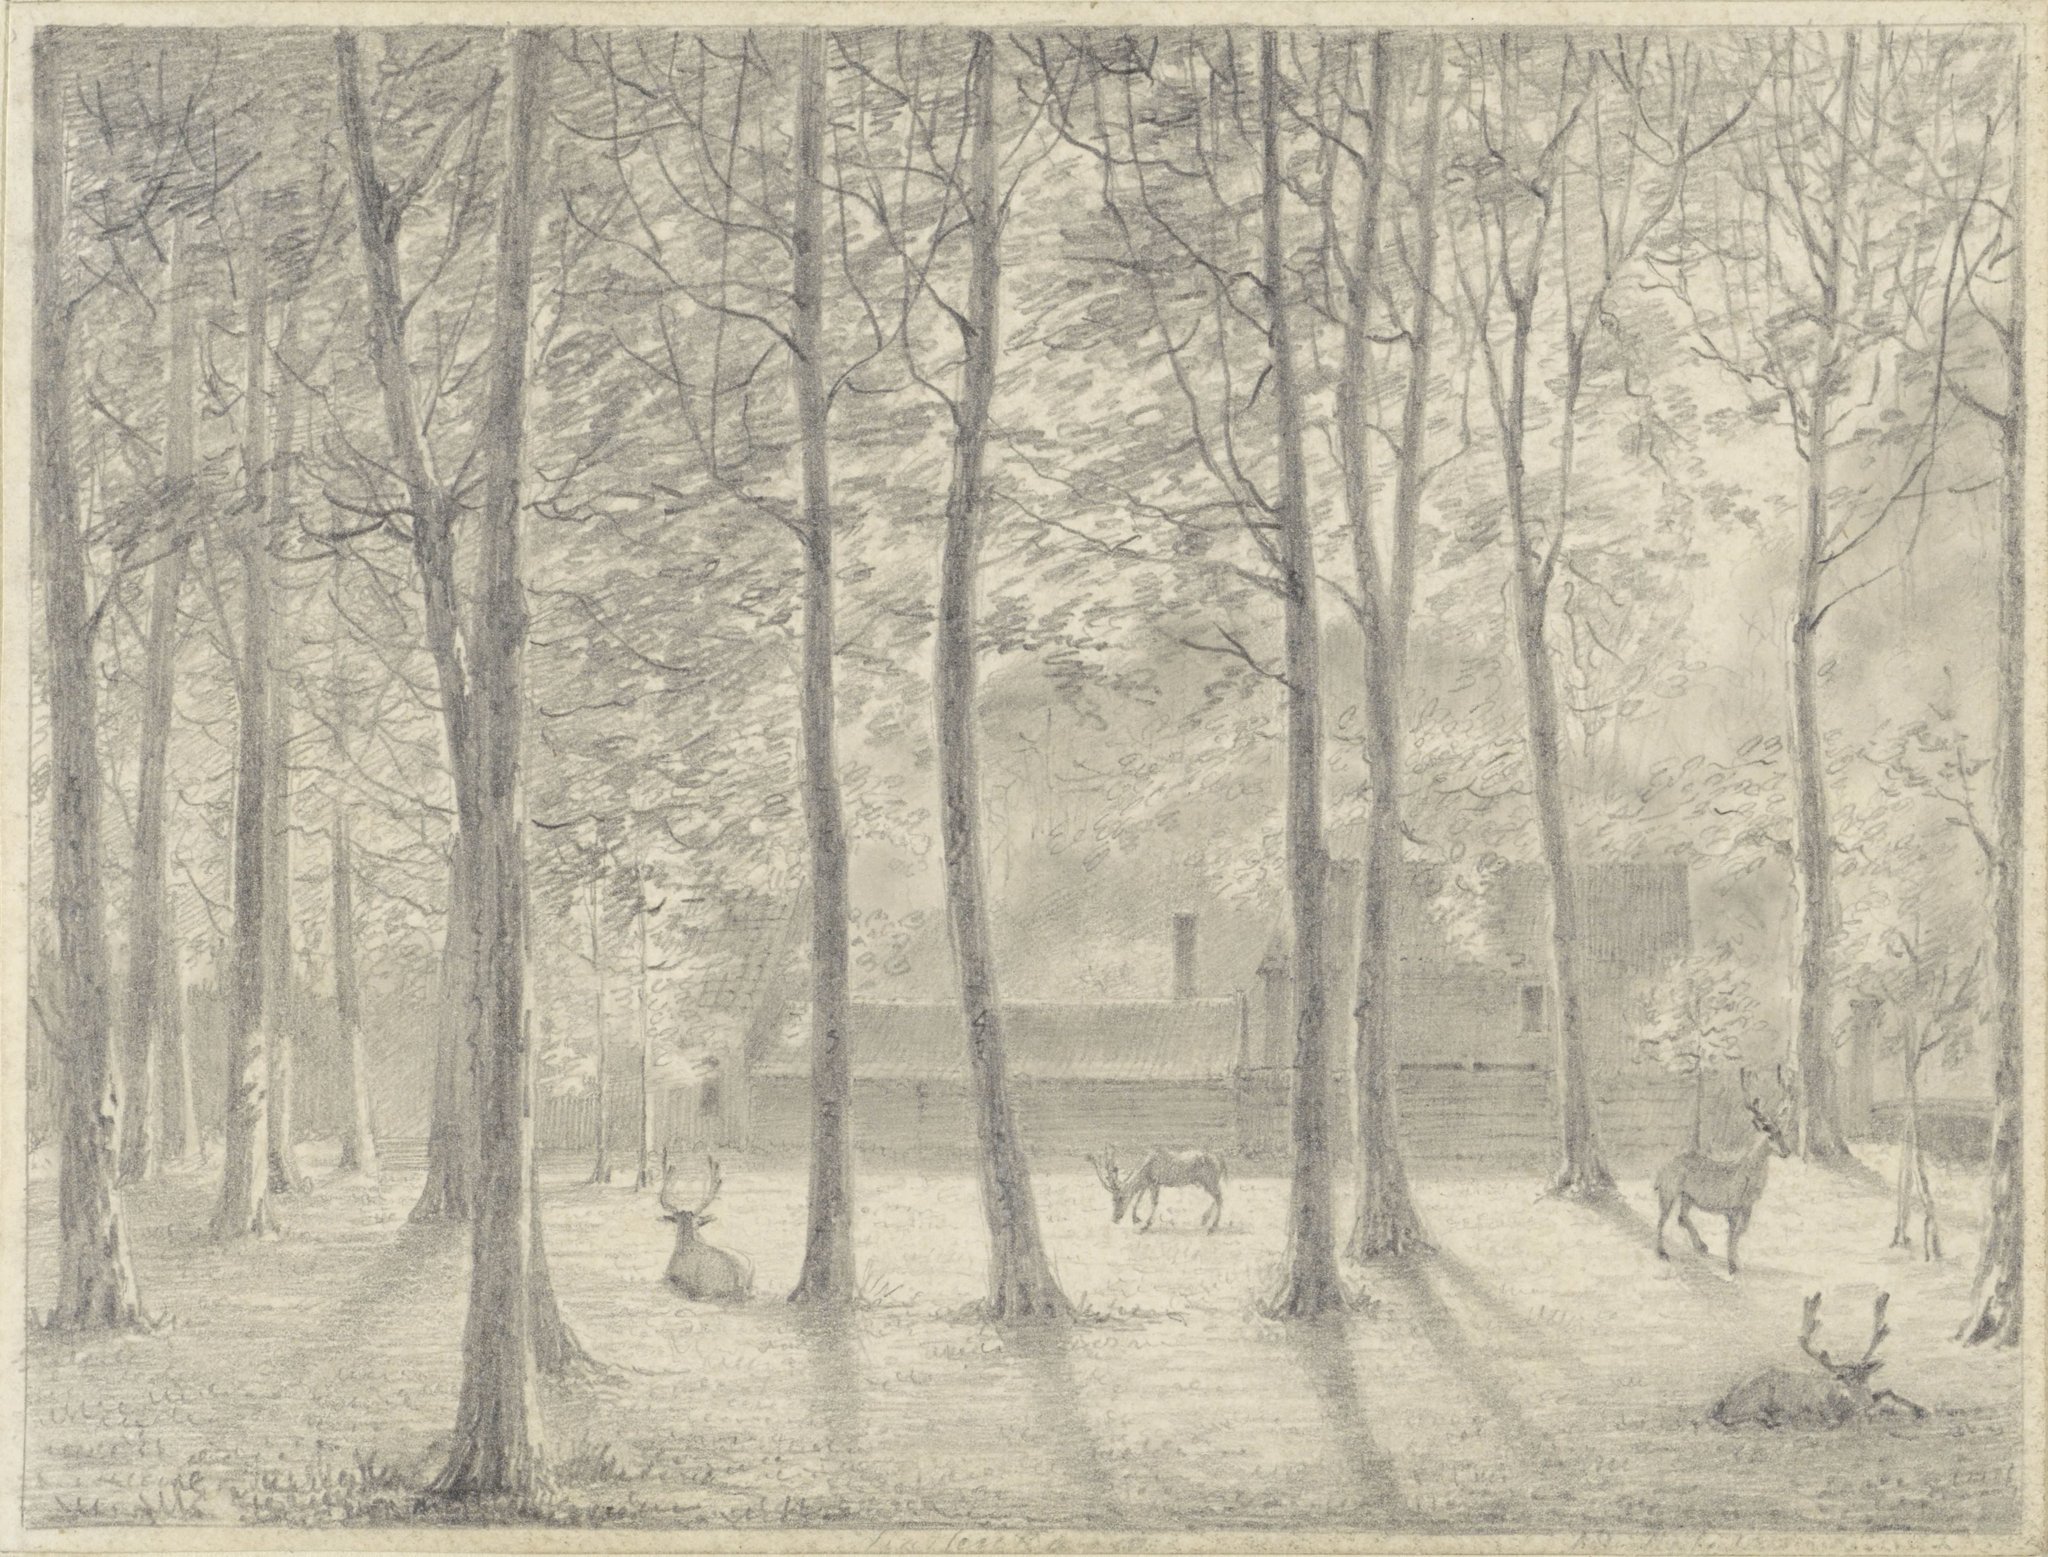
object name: drawing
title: hertenkamp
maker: hendrik abraham klinkhamer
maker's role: draughtsman, painter, print maker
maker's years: 1810-1872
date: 1838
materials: paper, pencil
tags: forest, wood, public gardens, park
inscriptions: inscription: ‘een gedeelte van de hertekamp in het haagsche bos’